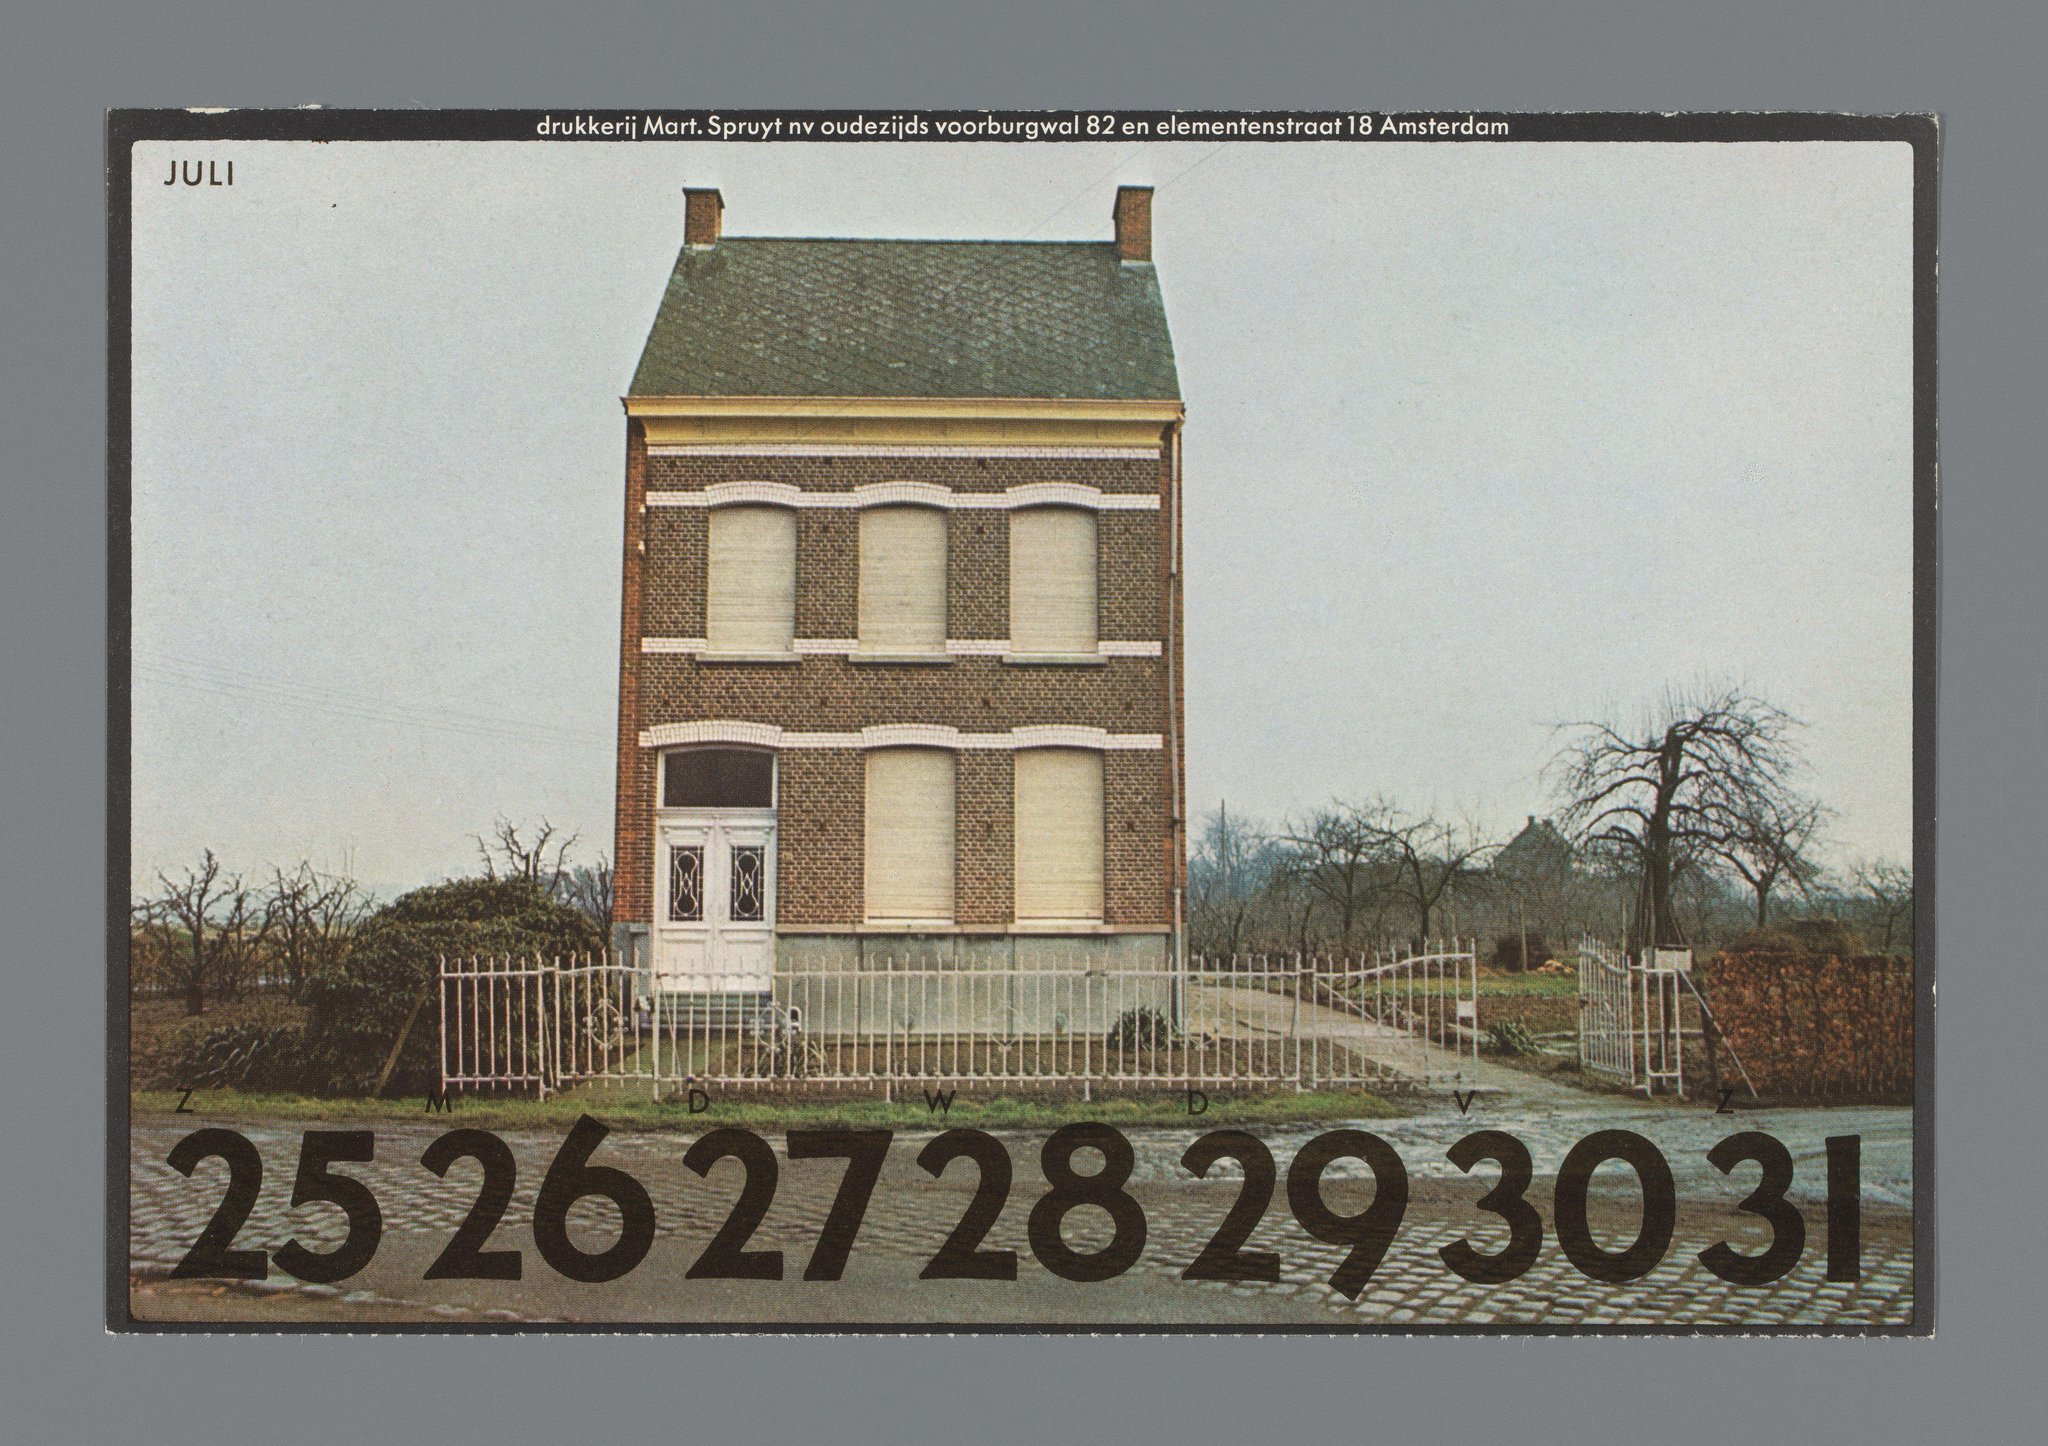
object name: photograph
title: België. Huizen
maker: Anonymous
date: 1900-1950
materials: paper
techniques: offset printed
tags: belgium